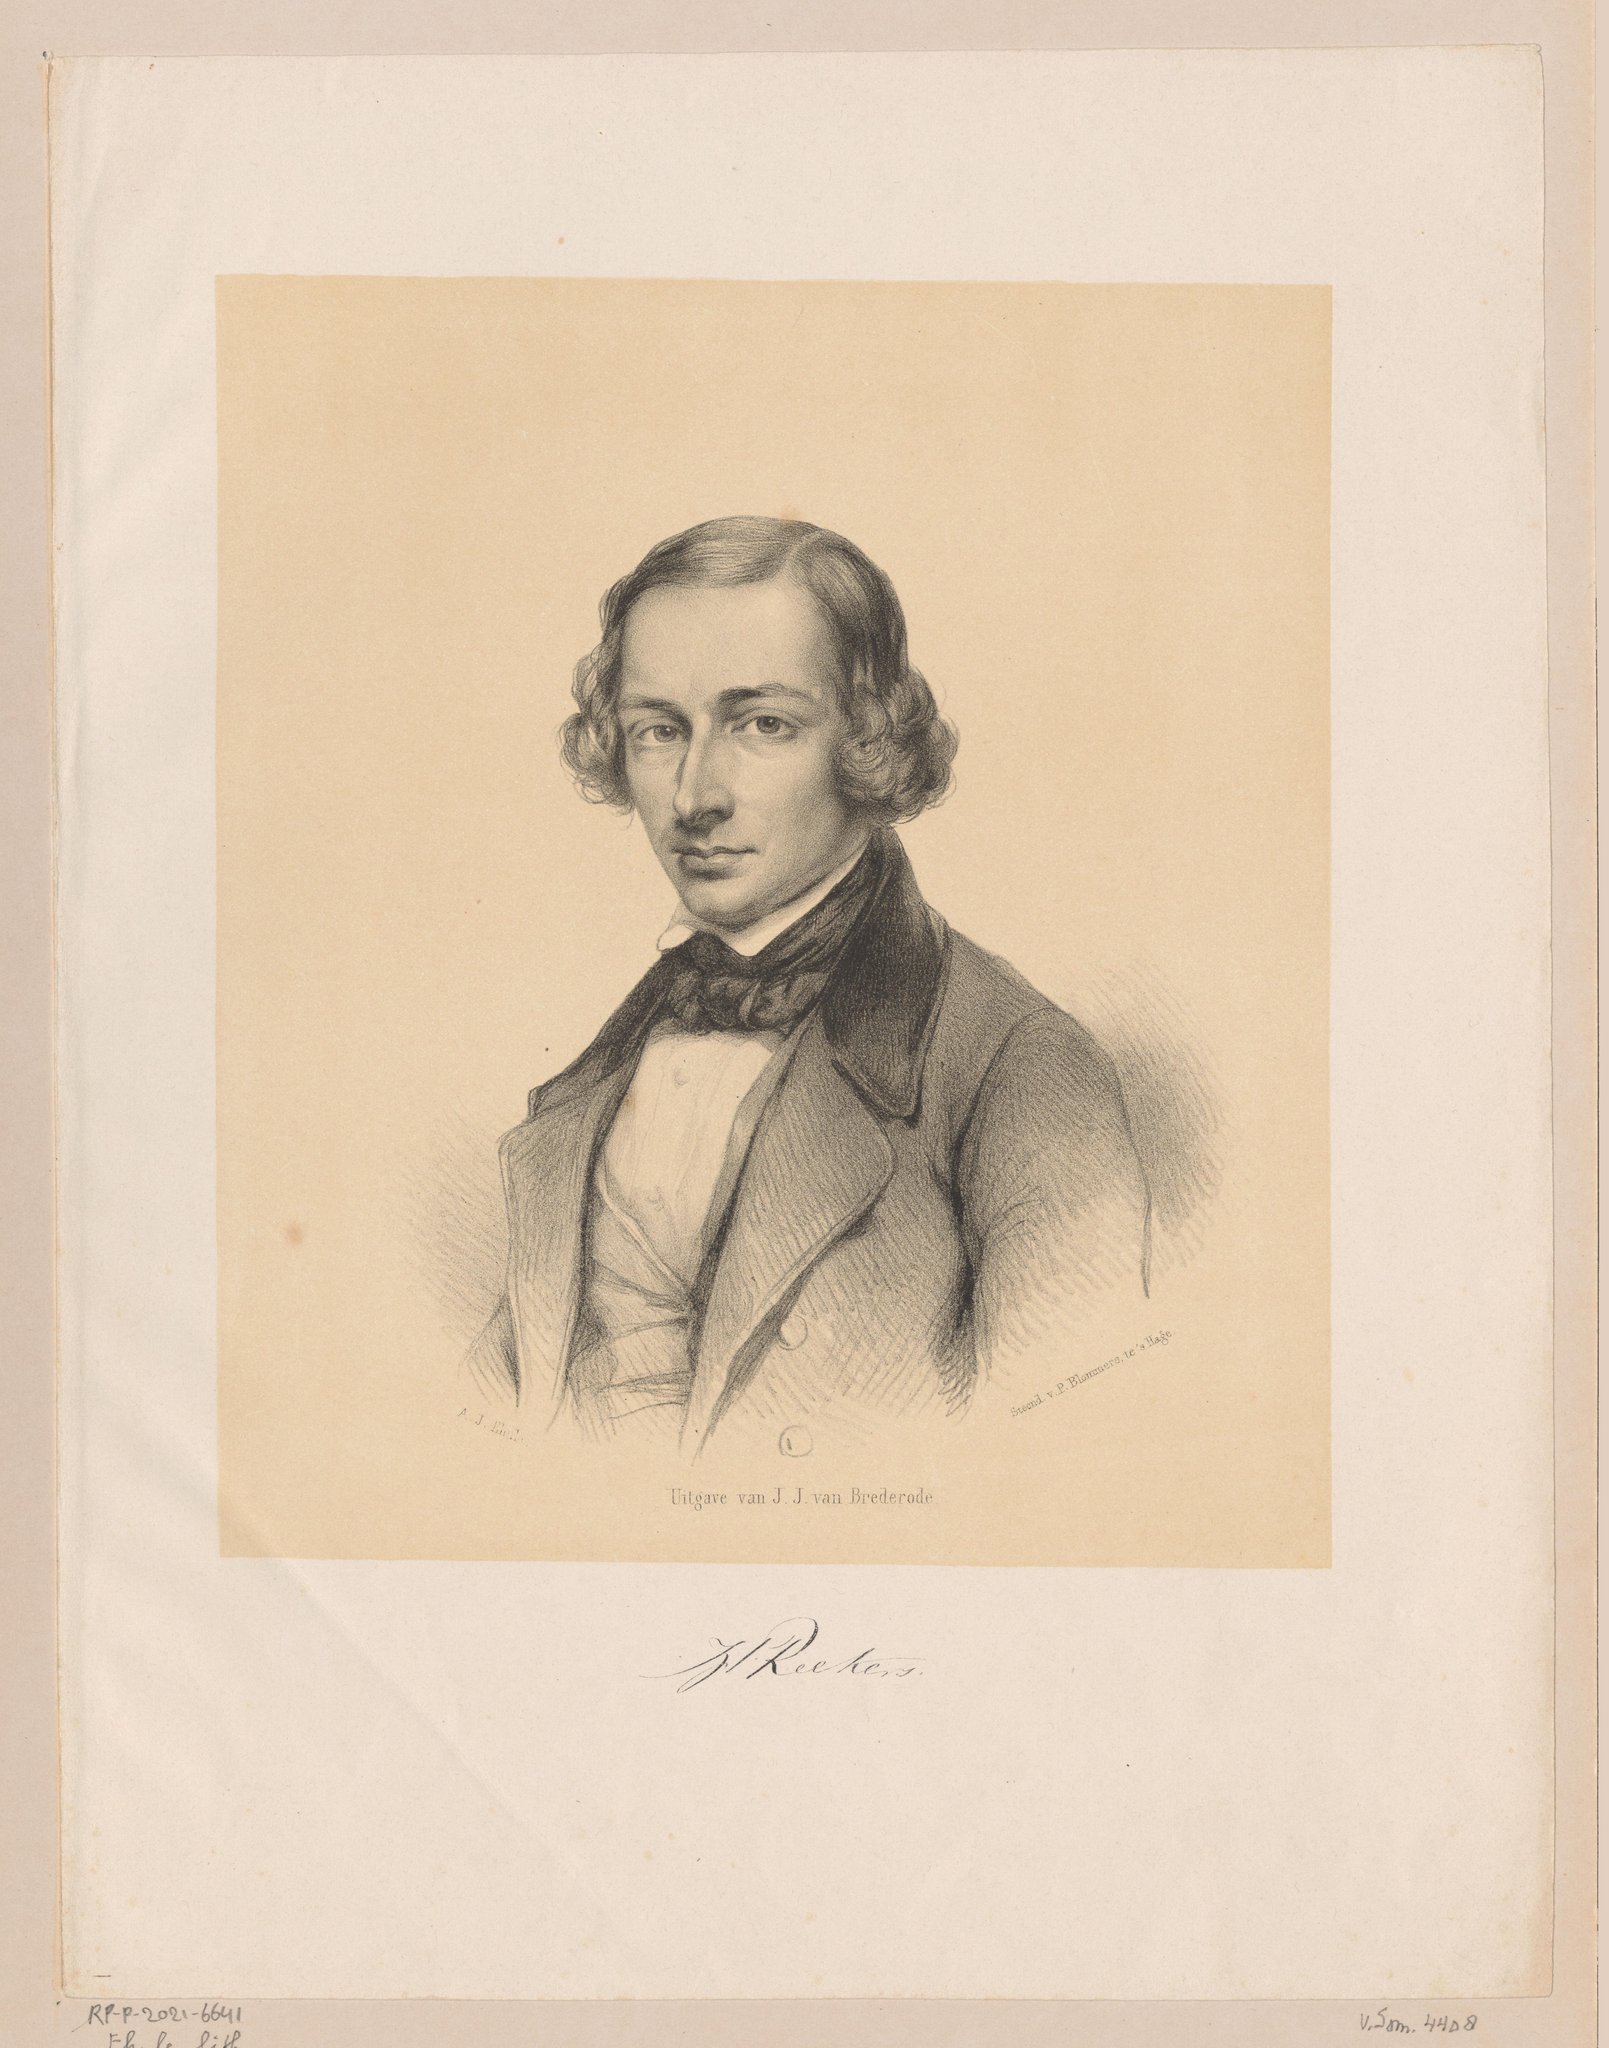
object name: print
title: Portret van Hendrik Reekers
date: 1847-1883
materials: paper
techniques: tone lithography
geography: haarlem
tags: painter, print maker, draughtsman, hendrik reekers, historical persons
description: Onder het portret een facsimile van de handtekening van de geportretteerde.